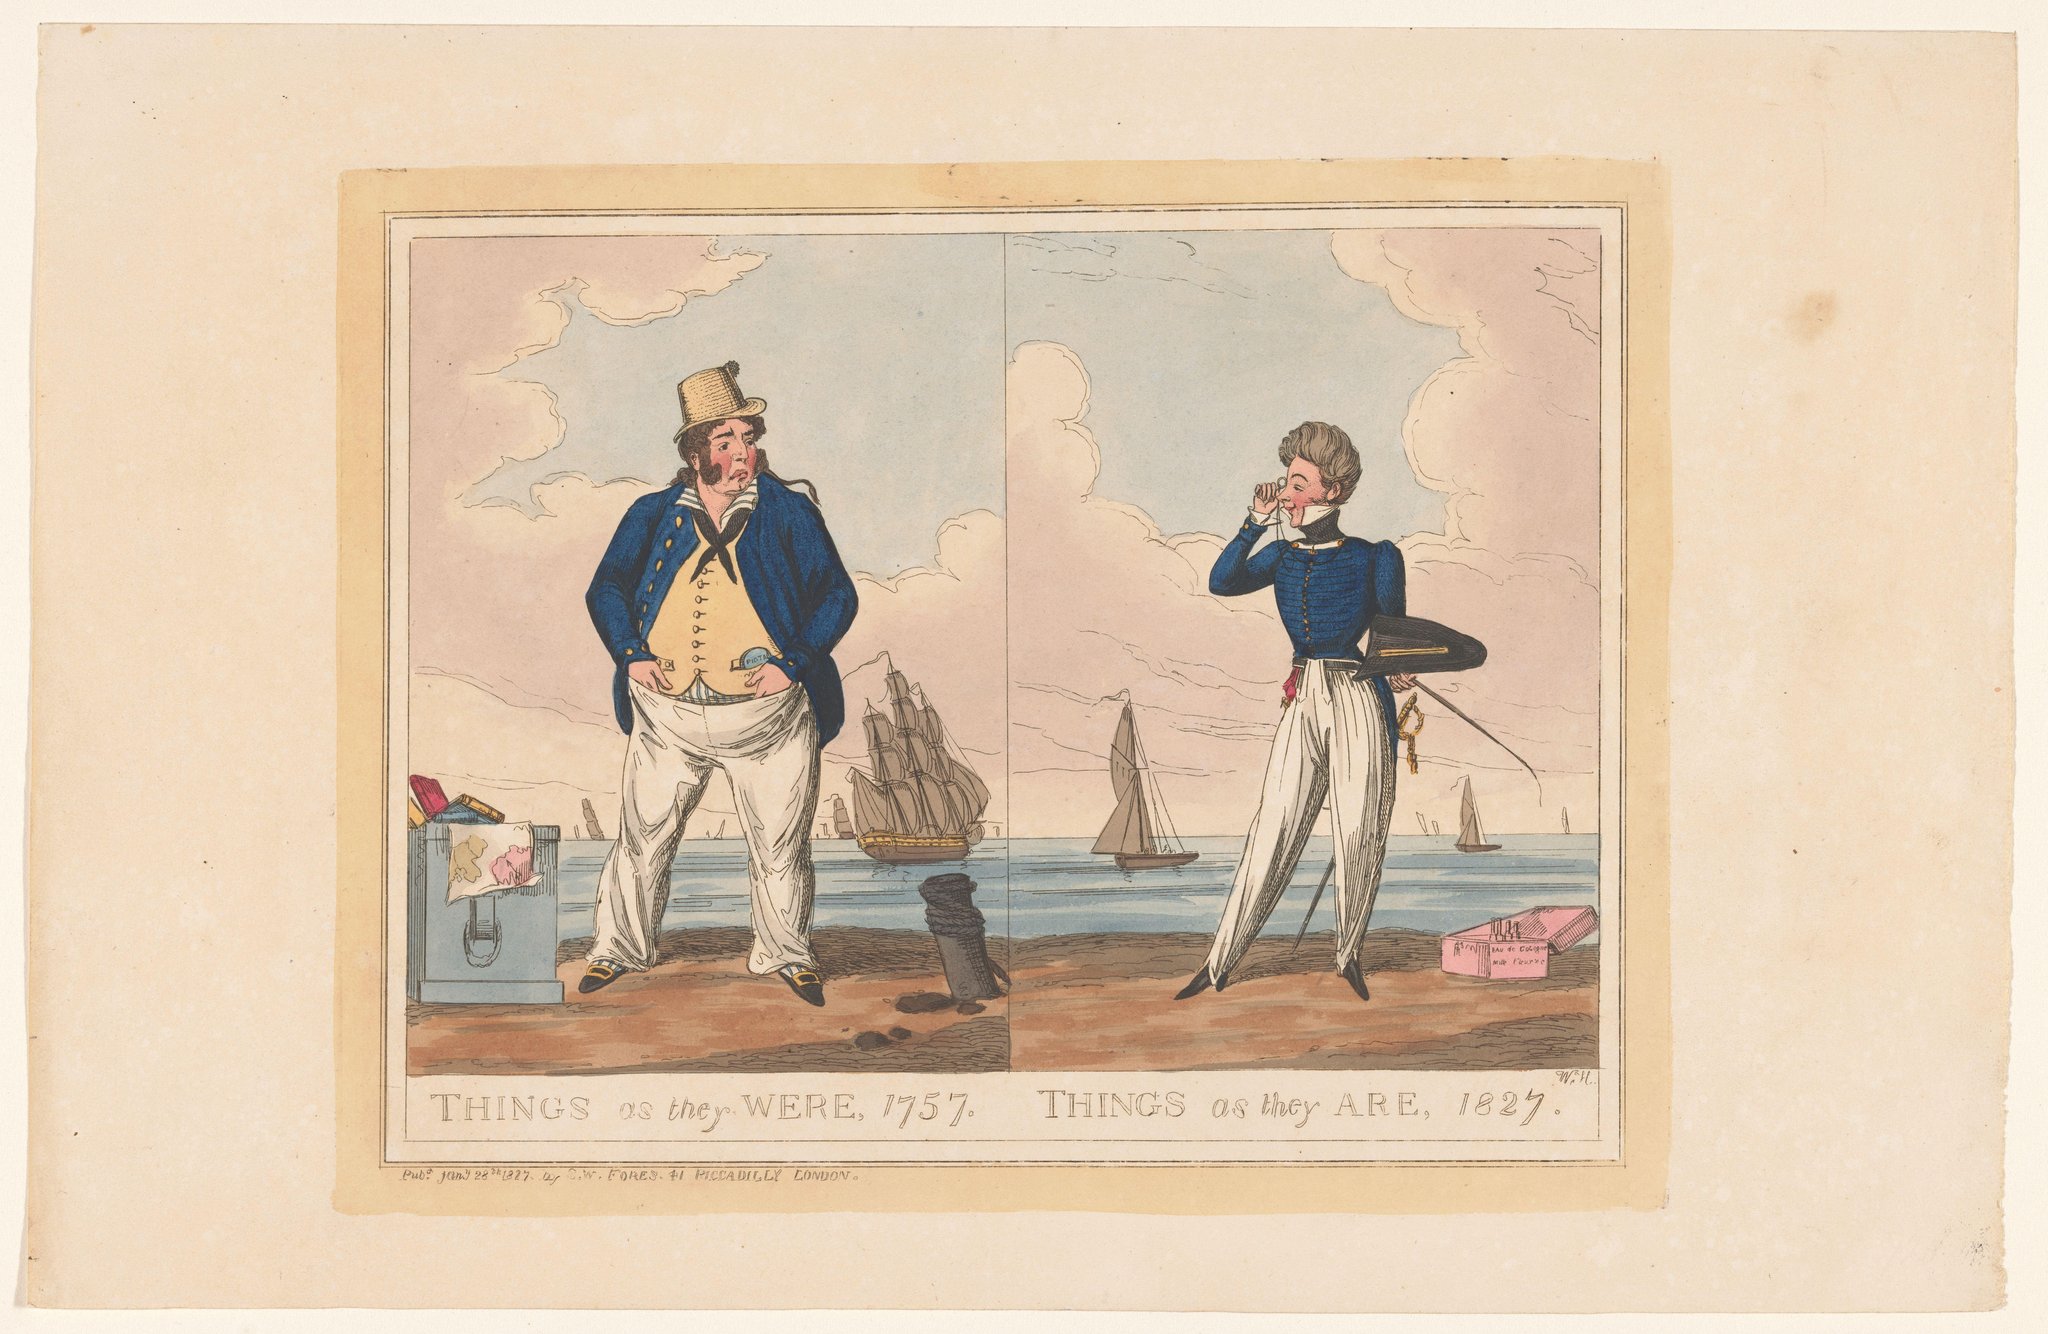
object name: cartoon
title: Spotprent op de veranderingen in de Britse Marine, 1827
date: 1827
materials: paper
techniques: etching, hand coloring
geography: london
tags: officer, political caricatures and satires, england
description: Spotprent op de veranderingen in de Britse Marine. Links een oudere forse matroos uit 1757, naast hem een kist met boeken en een kaart. Rechts een jonge dandyachtige zeeofficier van 1827, naast hem een kistje met flesjes eau de cologne.